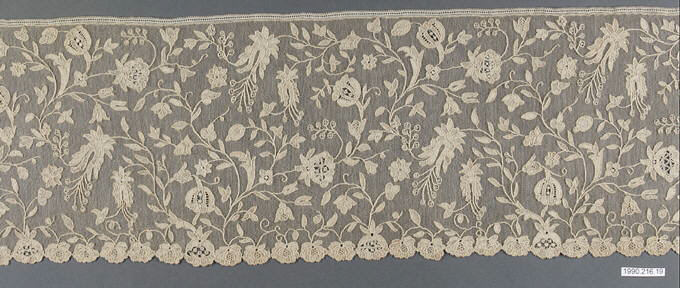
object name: border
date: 1867-1900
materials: cotton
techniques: lace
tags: flowers